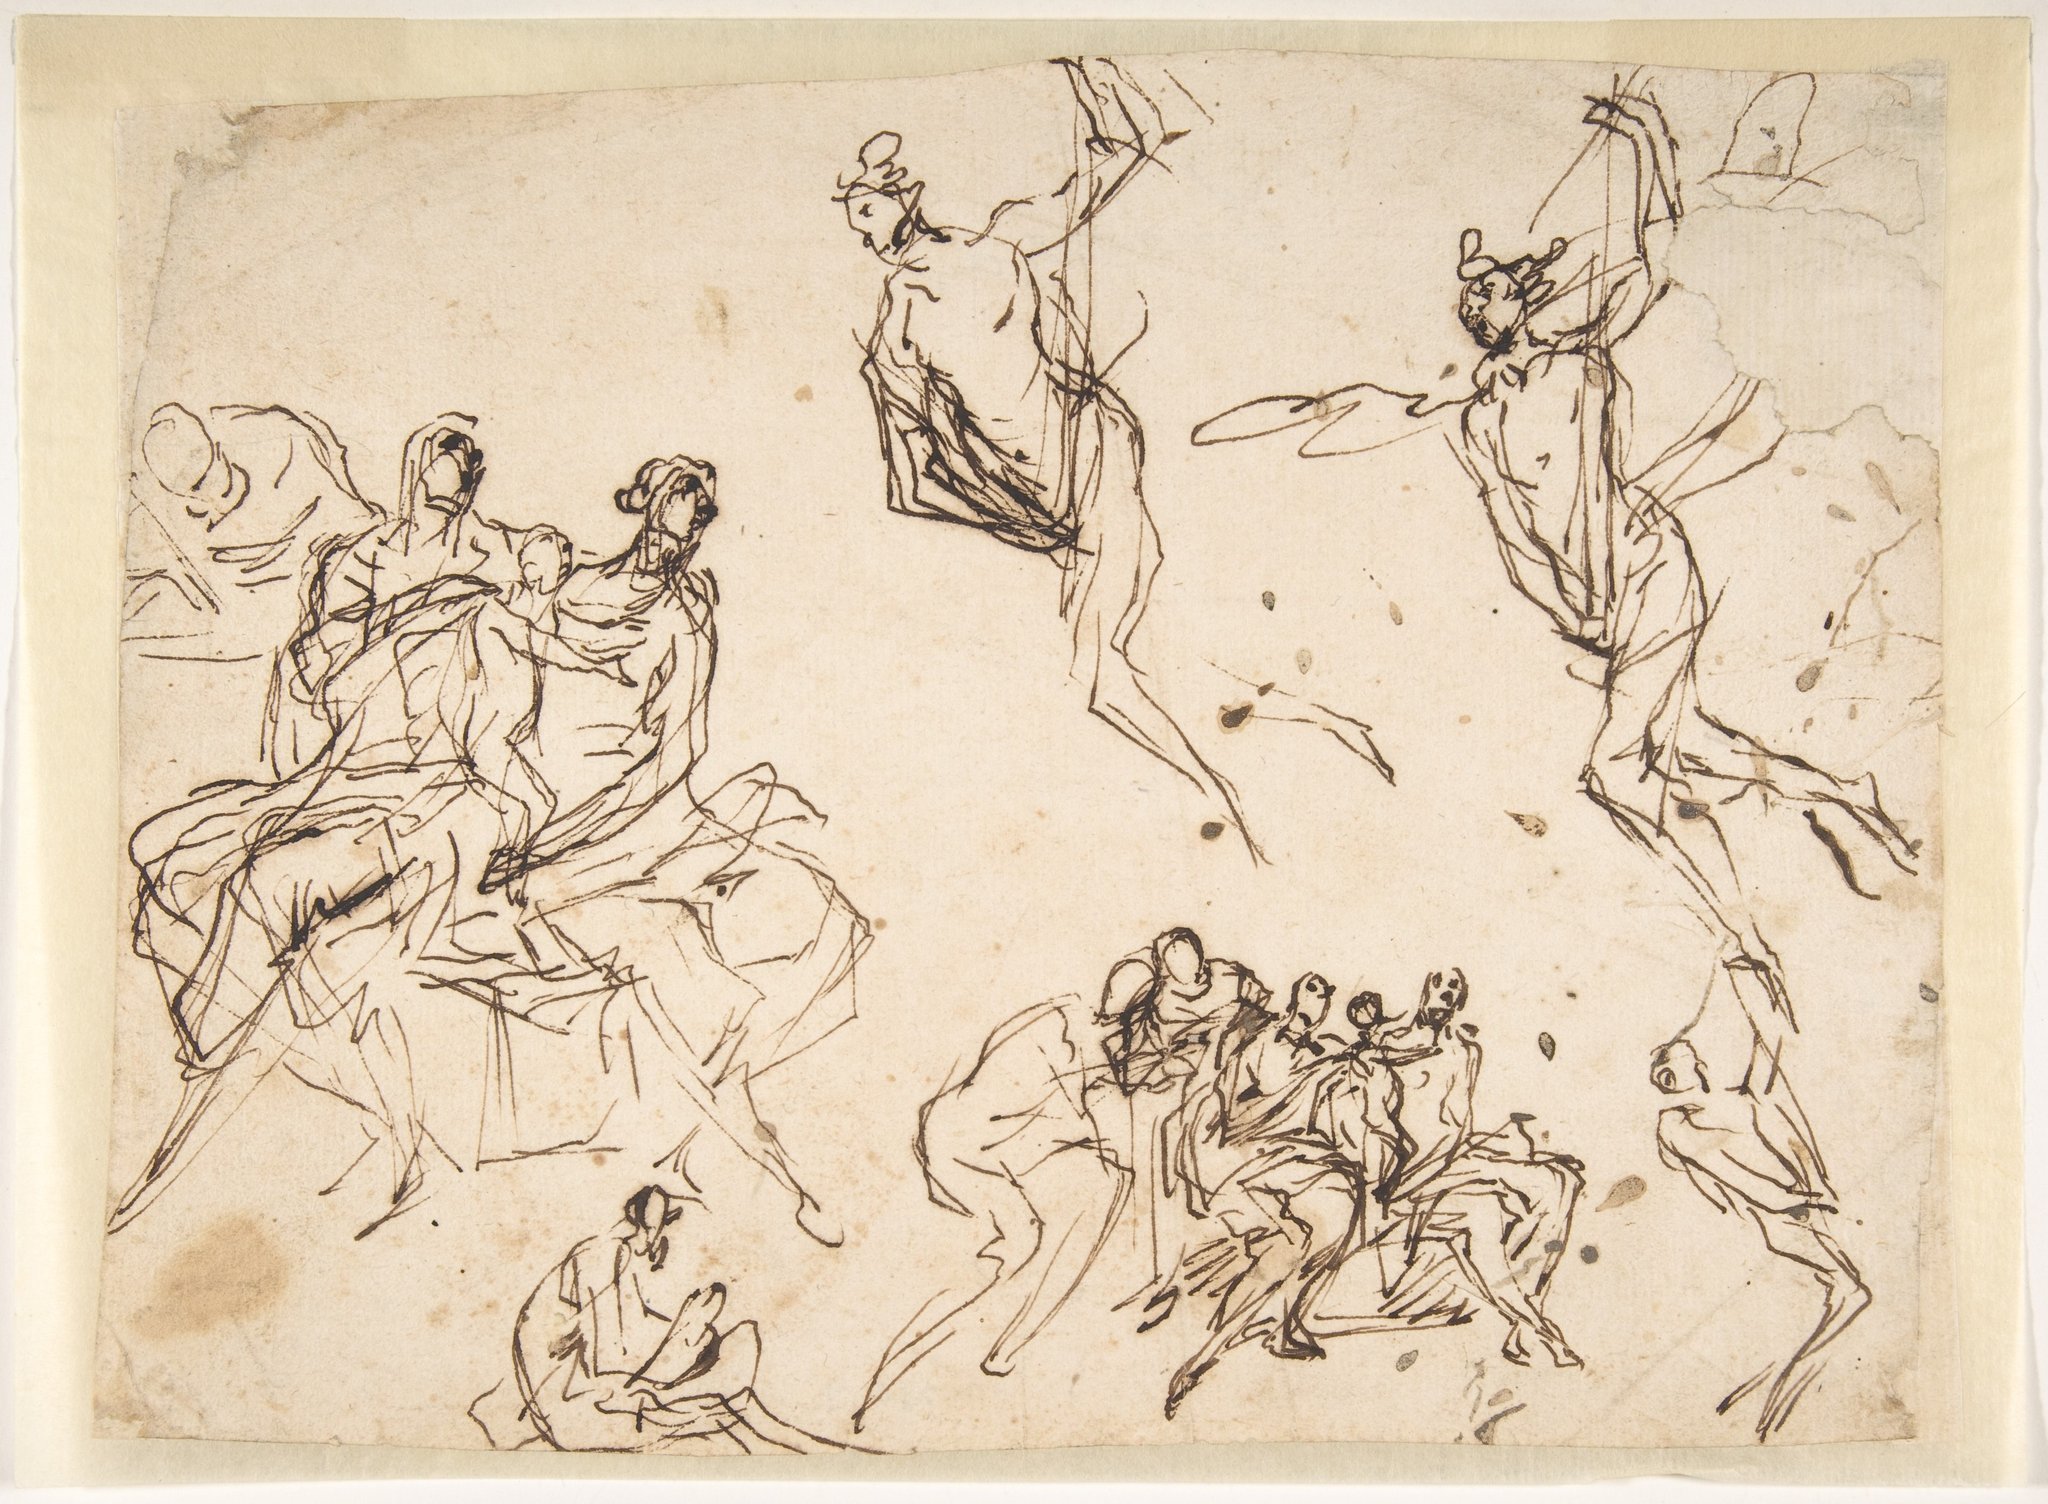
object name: drawing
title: Studies of a Group of Seated Figures and of a Flying Figure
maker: micco spadaro (domenico gargiulo)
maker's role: artist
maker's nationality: italian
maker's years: 1609-1675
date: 1612-1675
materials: ink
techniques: pen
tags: human figures